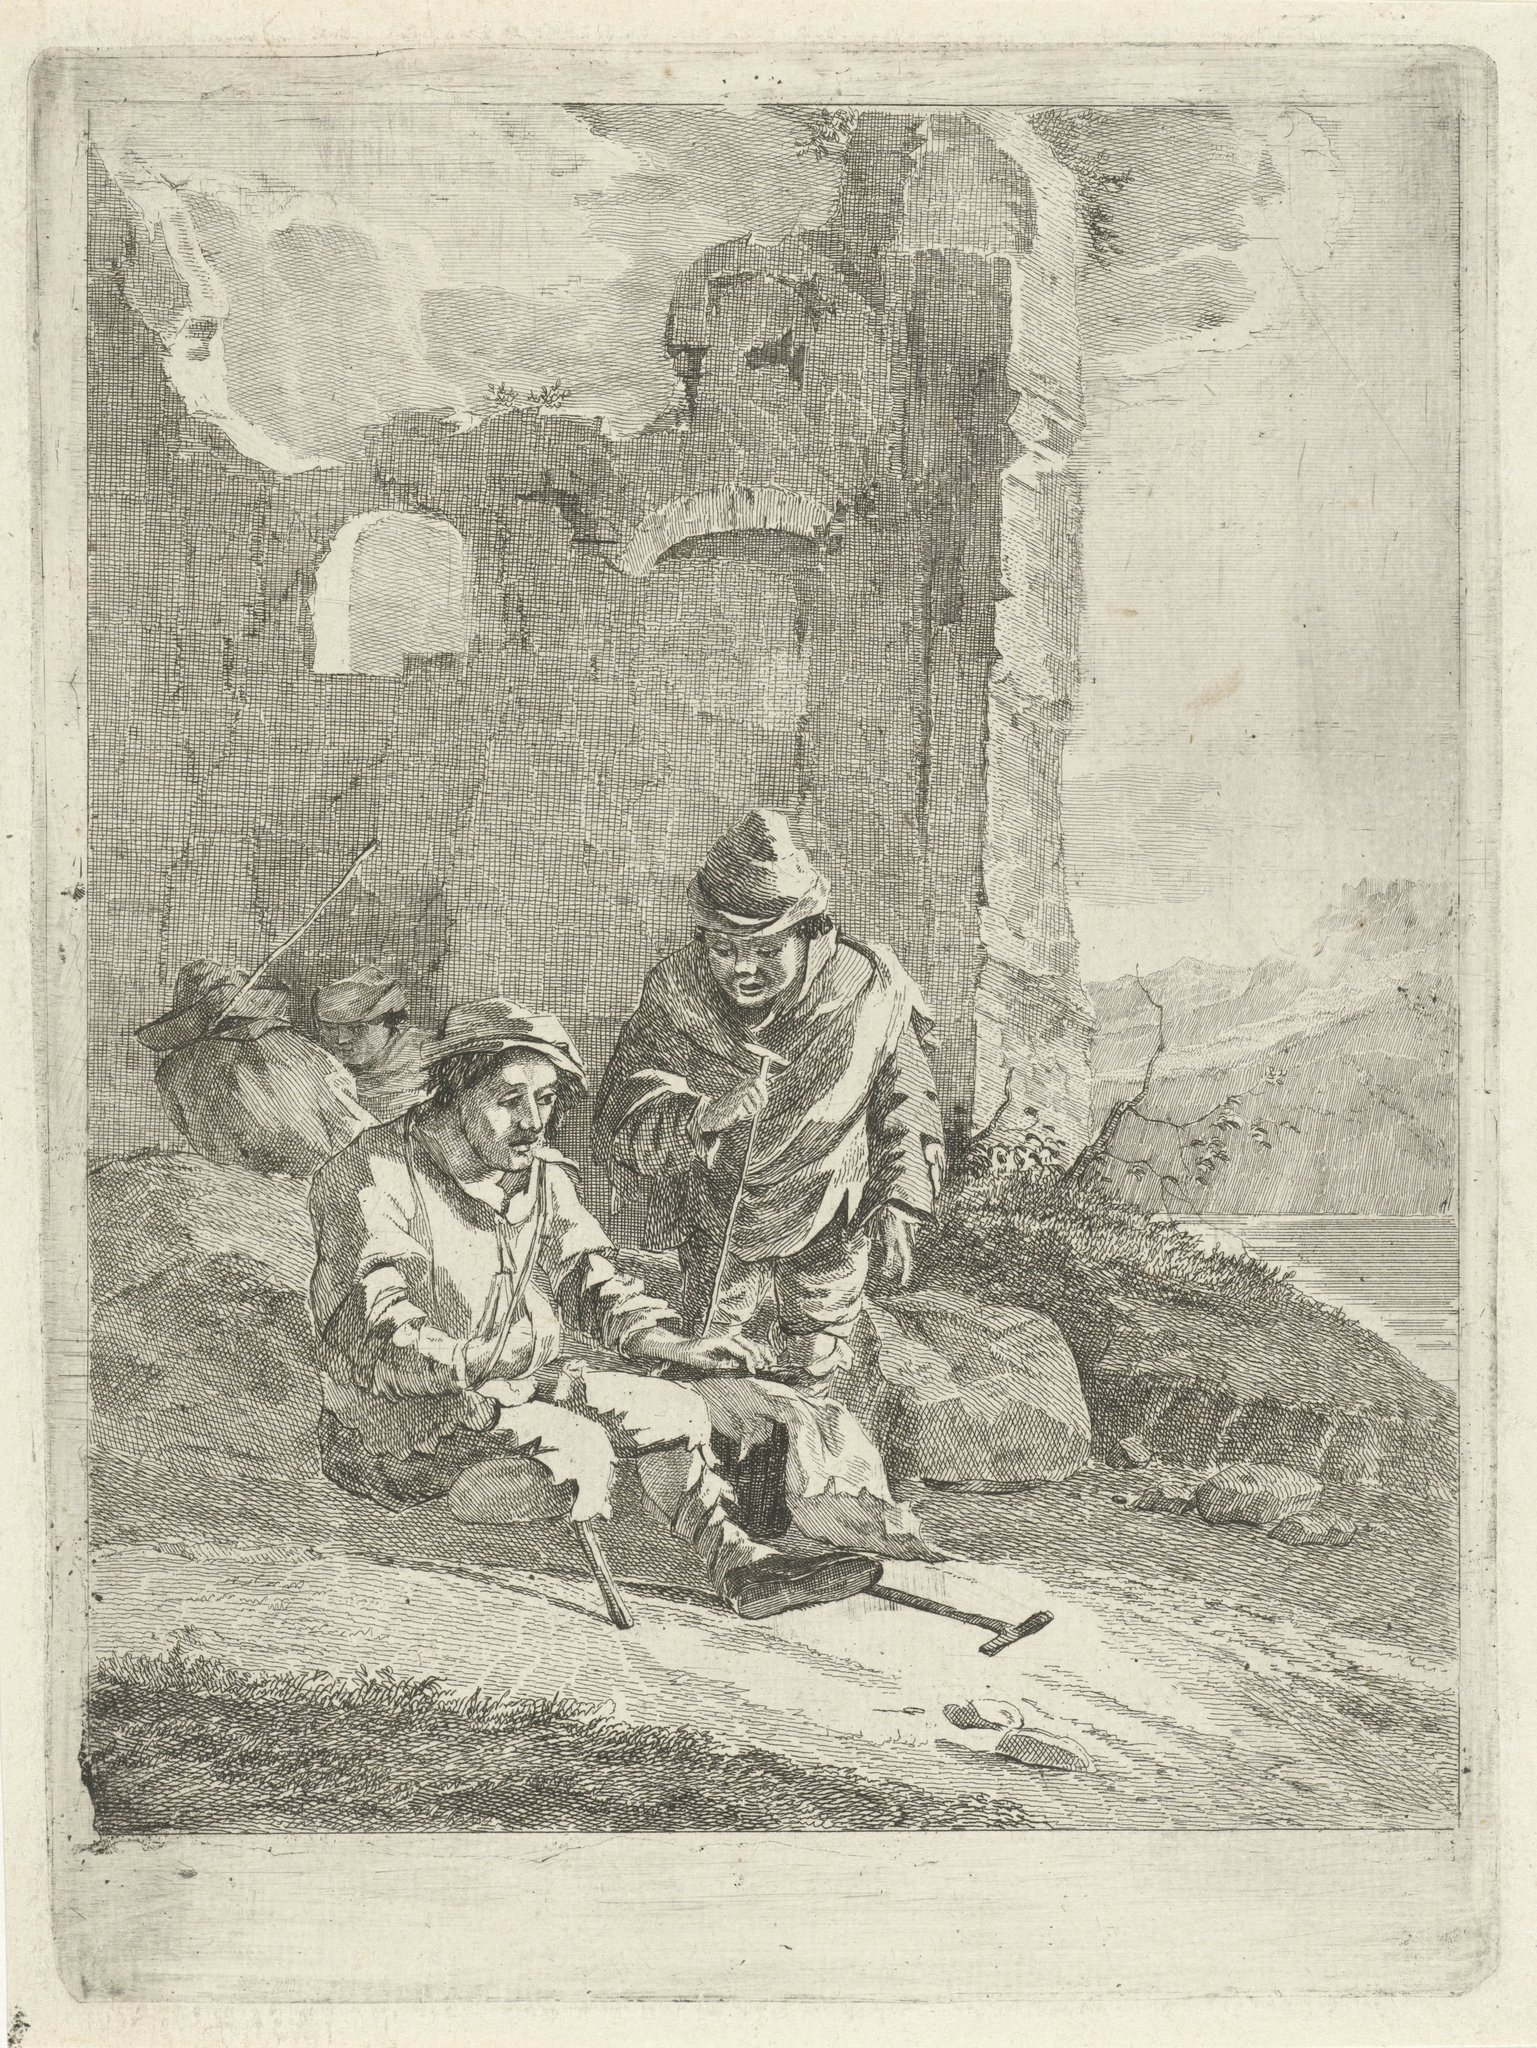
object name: print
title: Vier figuren bij een ruïne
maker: gerrit groenewegen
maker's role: draughtsman, print maker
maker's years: 1754-1826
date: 1764-1826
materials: paper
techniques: etching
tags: leprosy (+ number of persons)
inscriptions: collector's mark: Lugt 2228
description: Vier figuren, waarvan er twee aan lepra lijden, bij een ruïne. Een van de twee mannen op de voorgrond heeft een houten been en draagt een mitella.